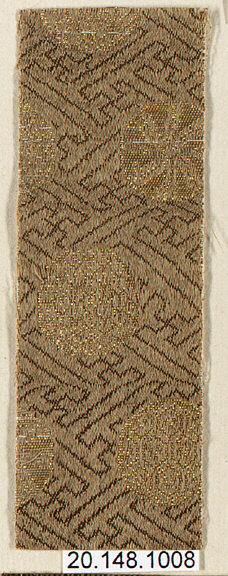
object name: piece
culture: japanese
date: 1801-1900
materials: silk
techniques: compound weave